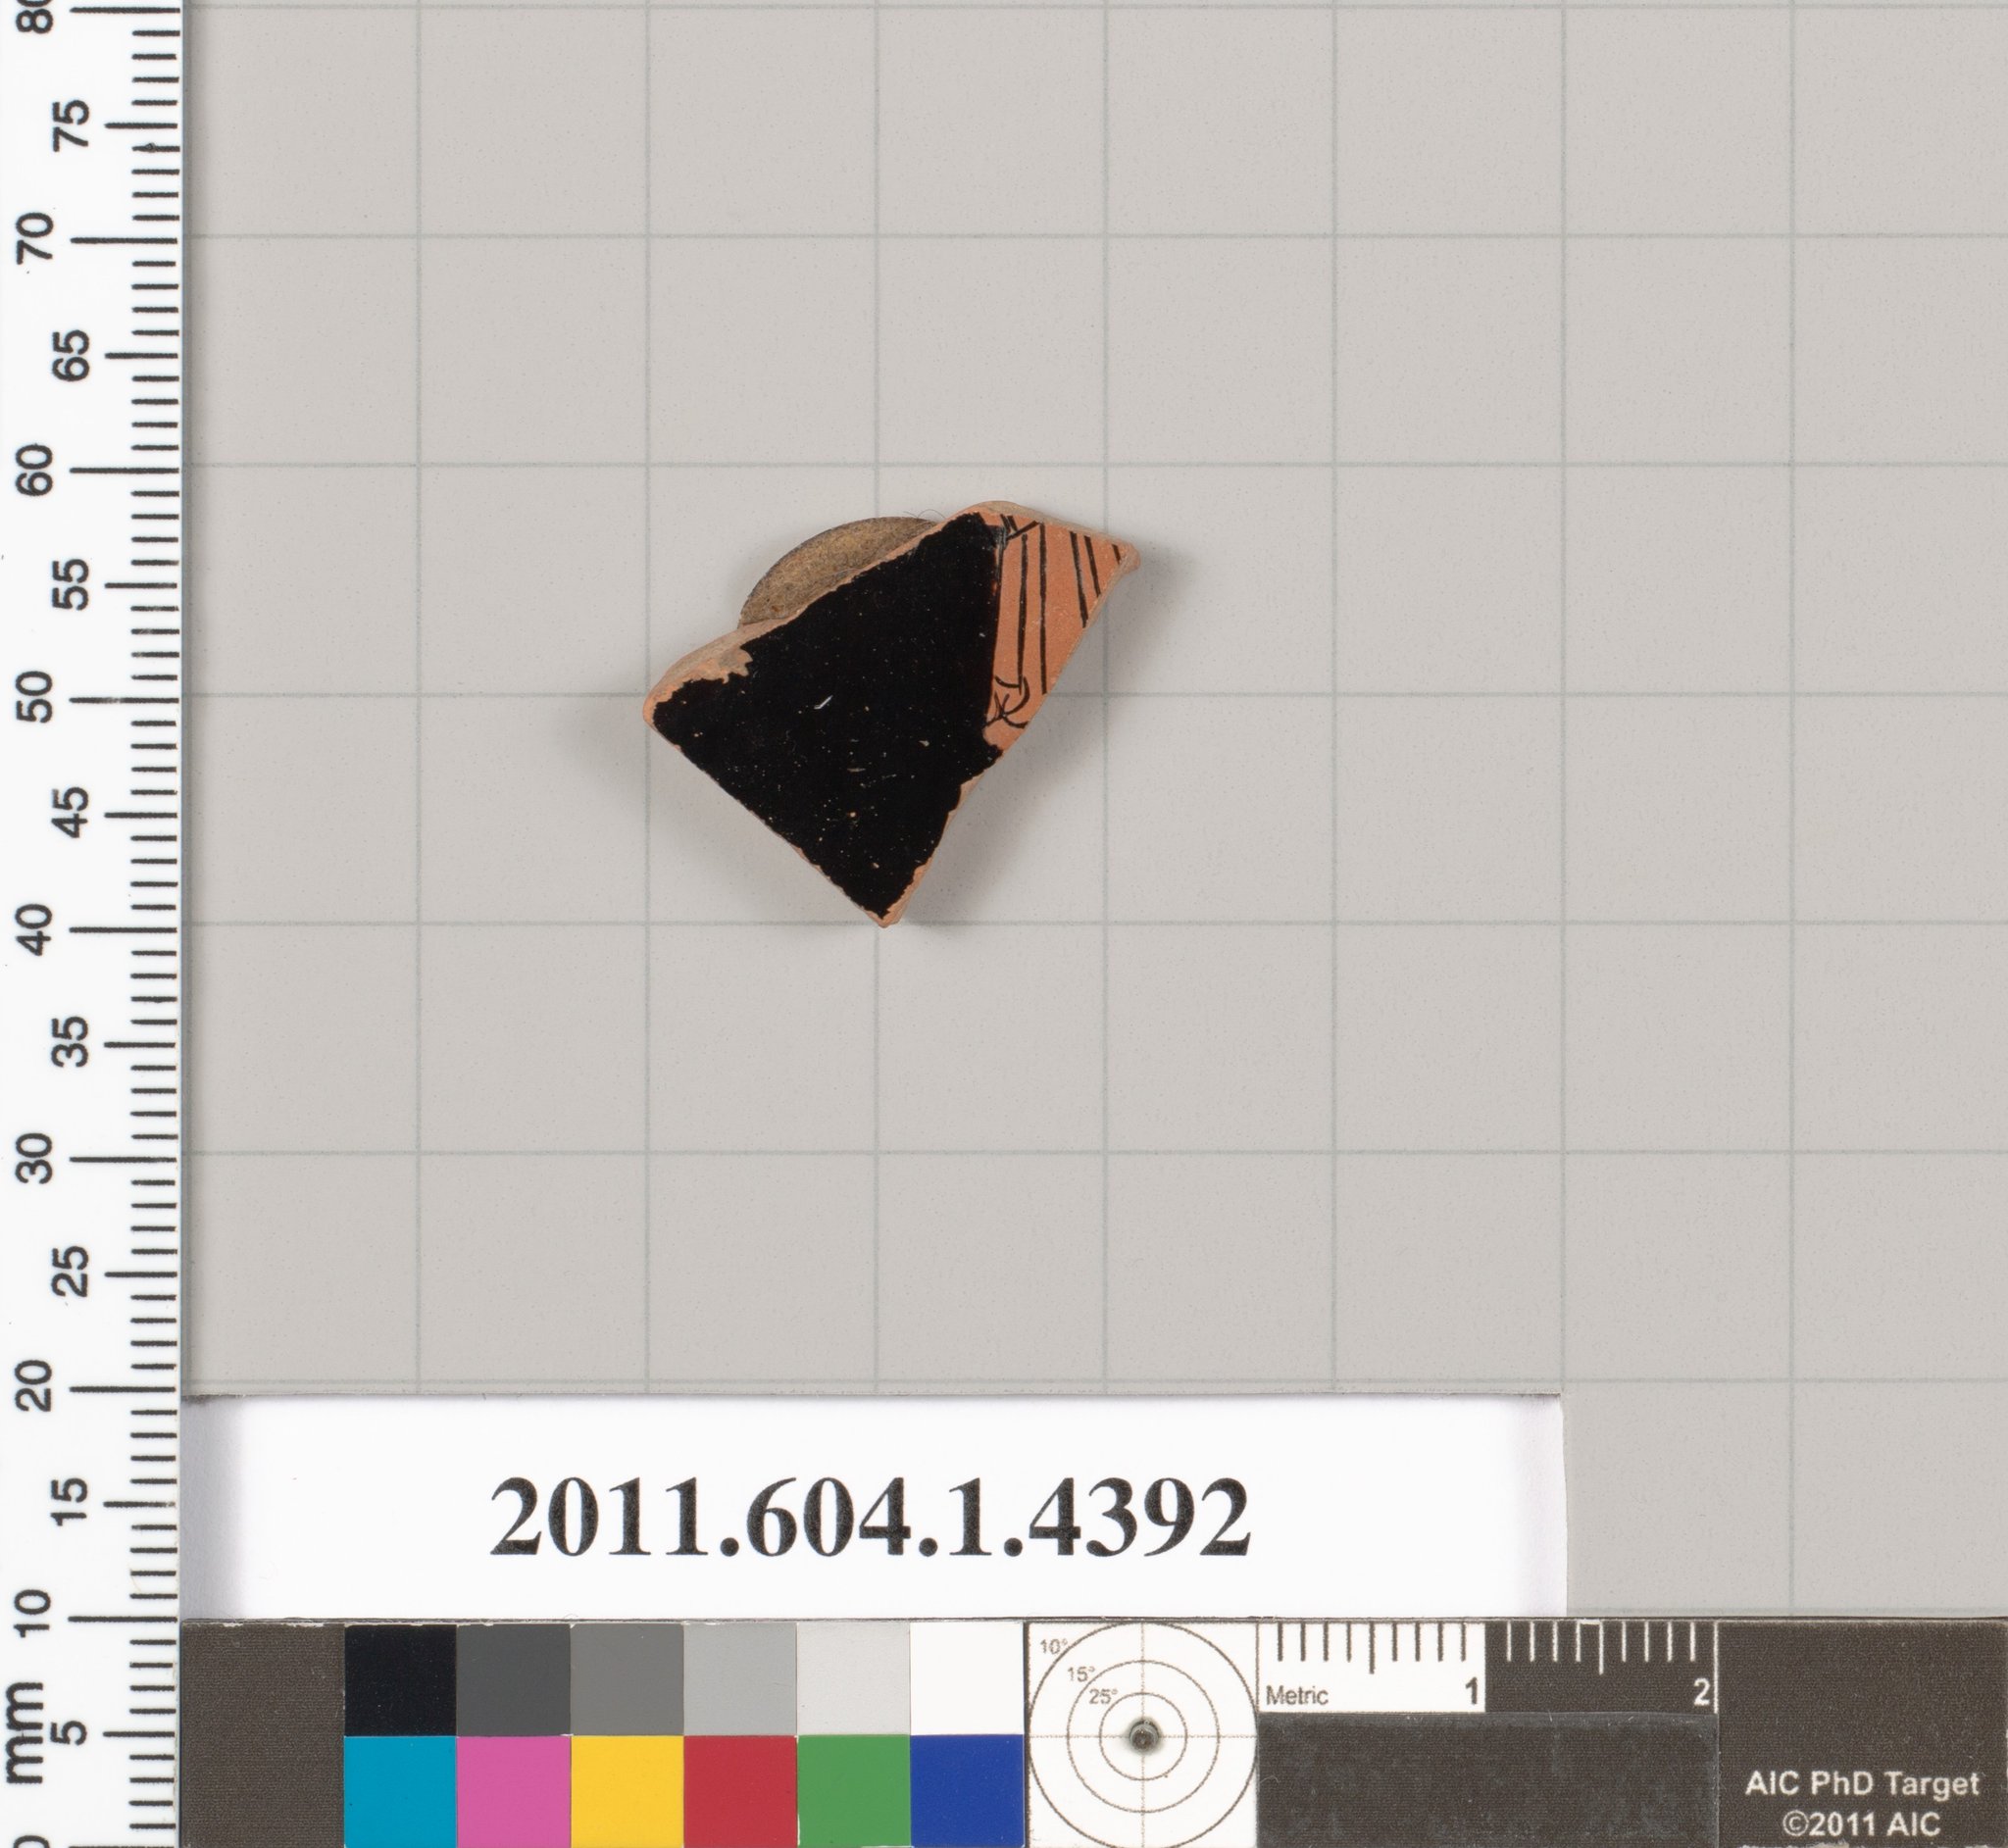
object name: kylix fragment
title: Terracotta fragment of a kylix (drinking cup)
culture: greek, attic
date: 490-470 BCE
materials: terracotta